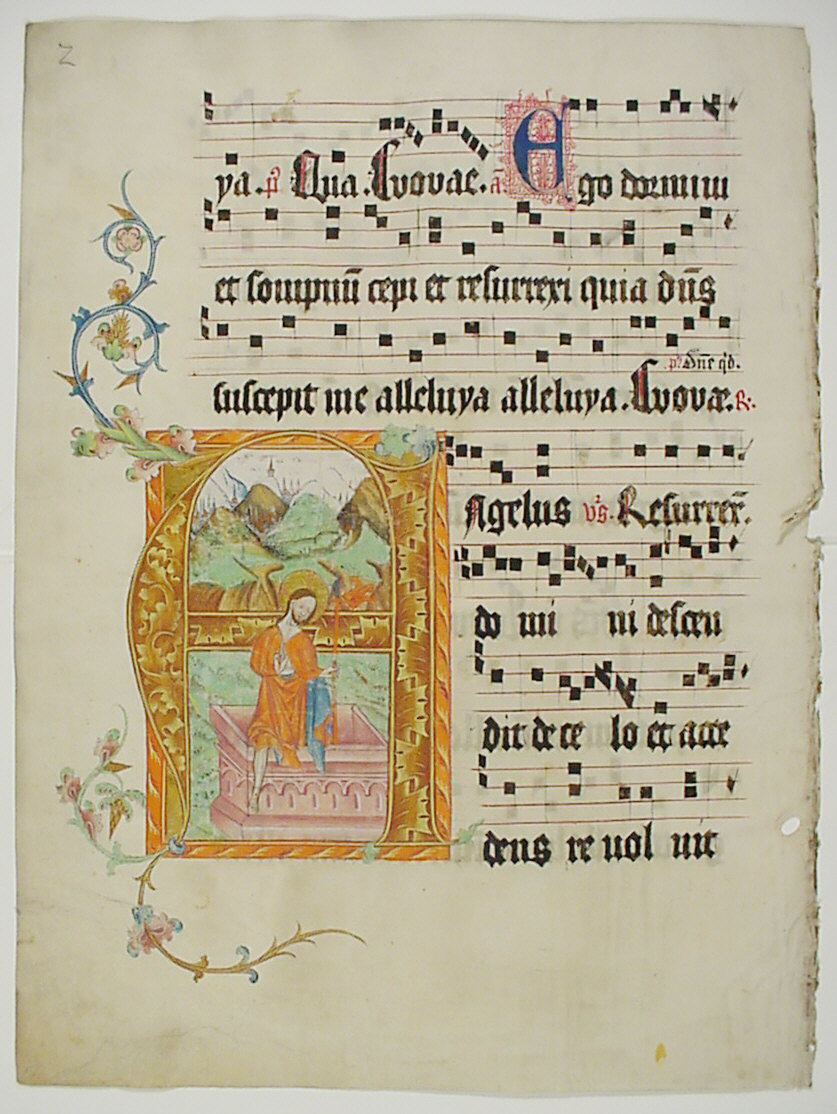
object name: gradual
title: Manuscript Leaf with Initial A, from a Gradual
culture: german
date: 1426-1450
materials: ink, metal leaf, parchment, paint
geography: germany